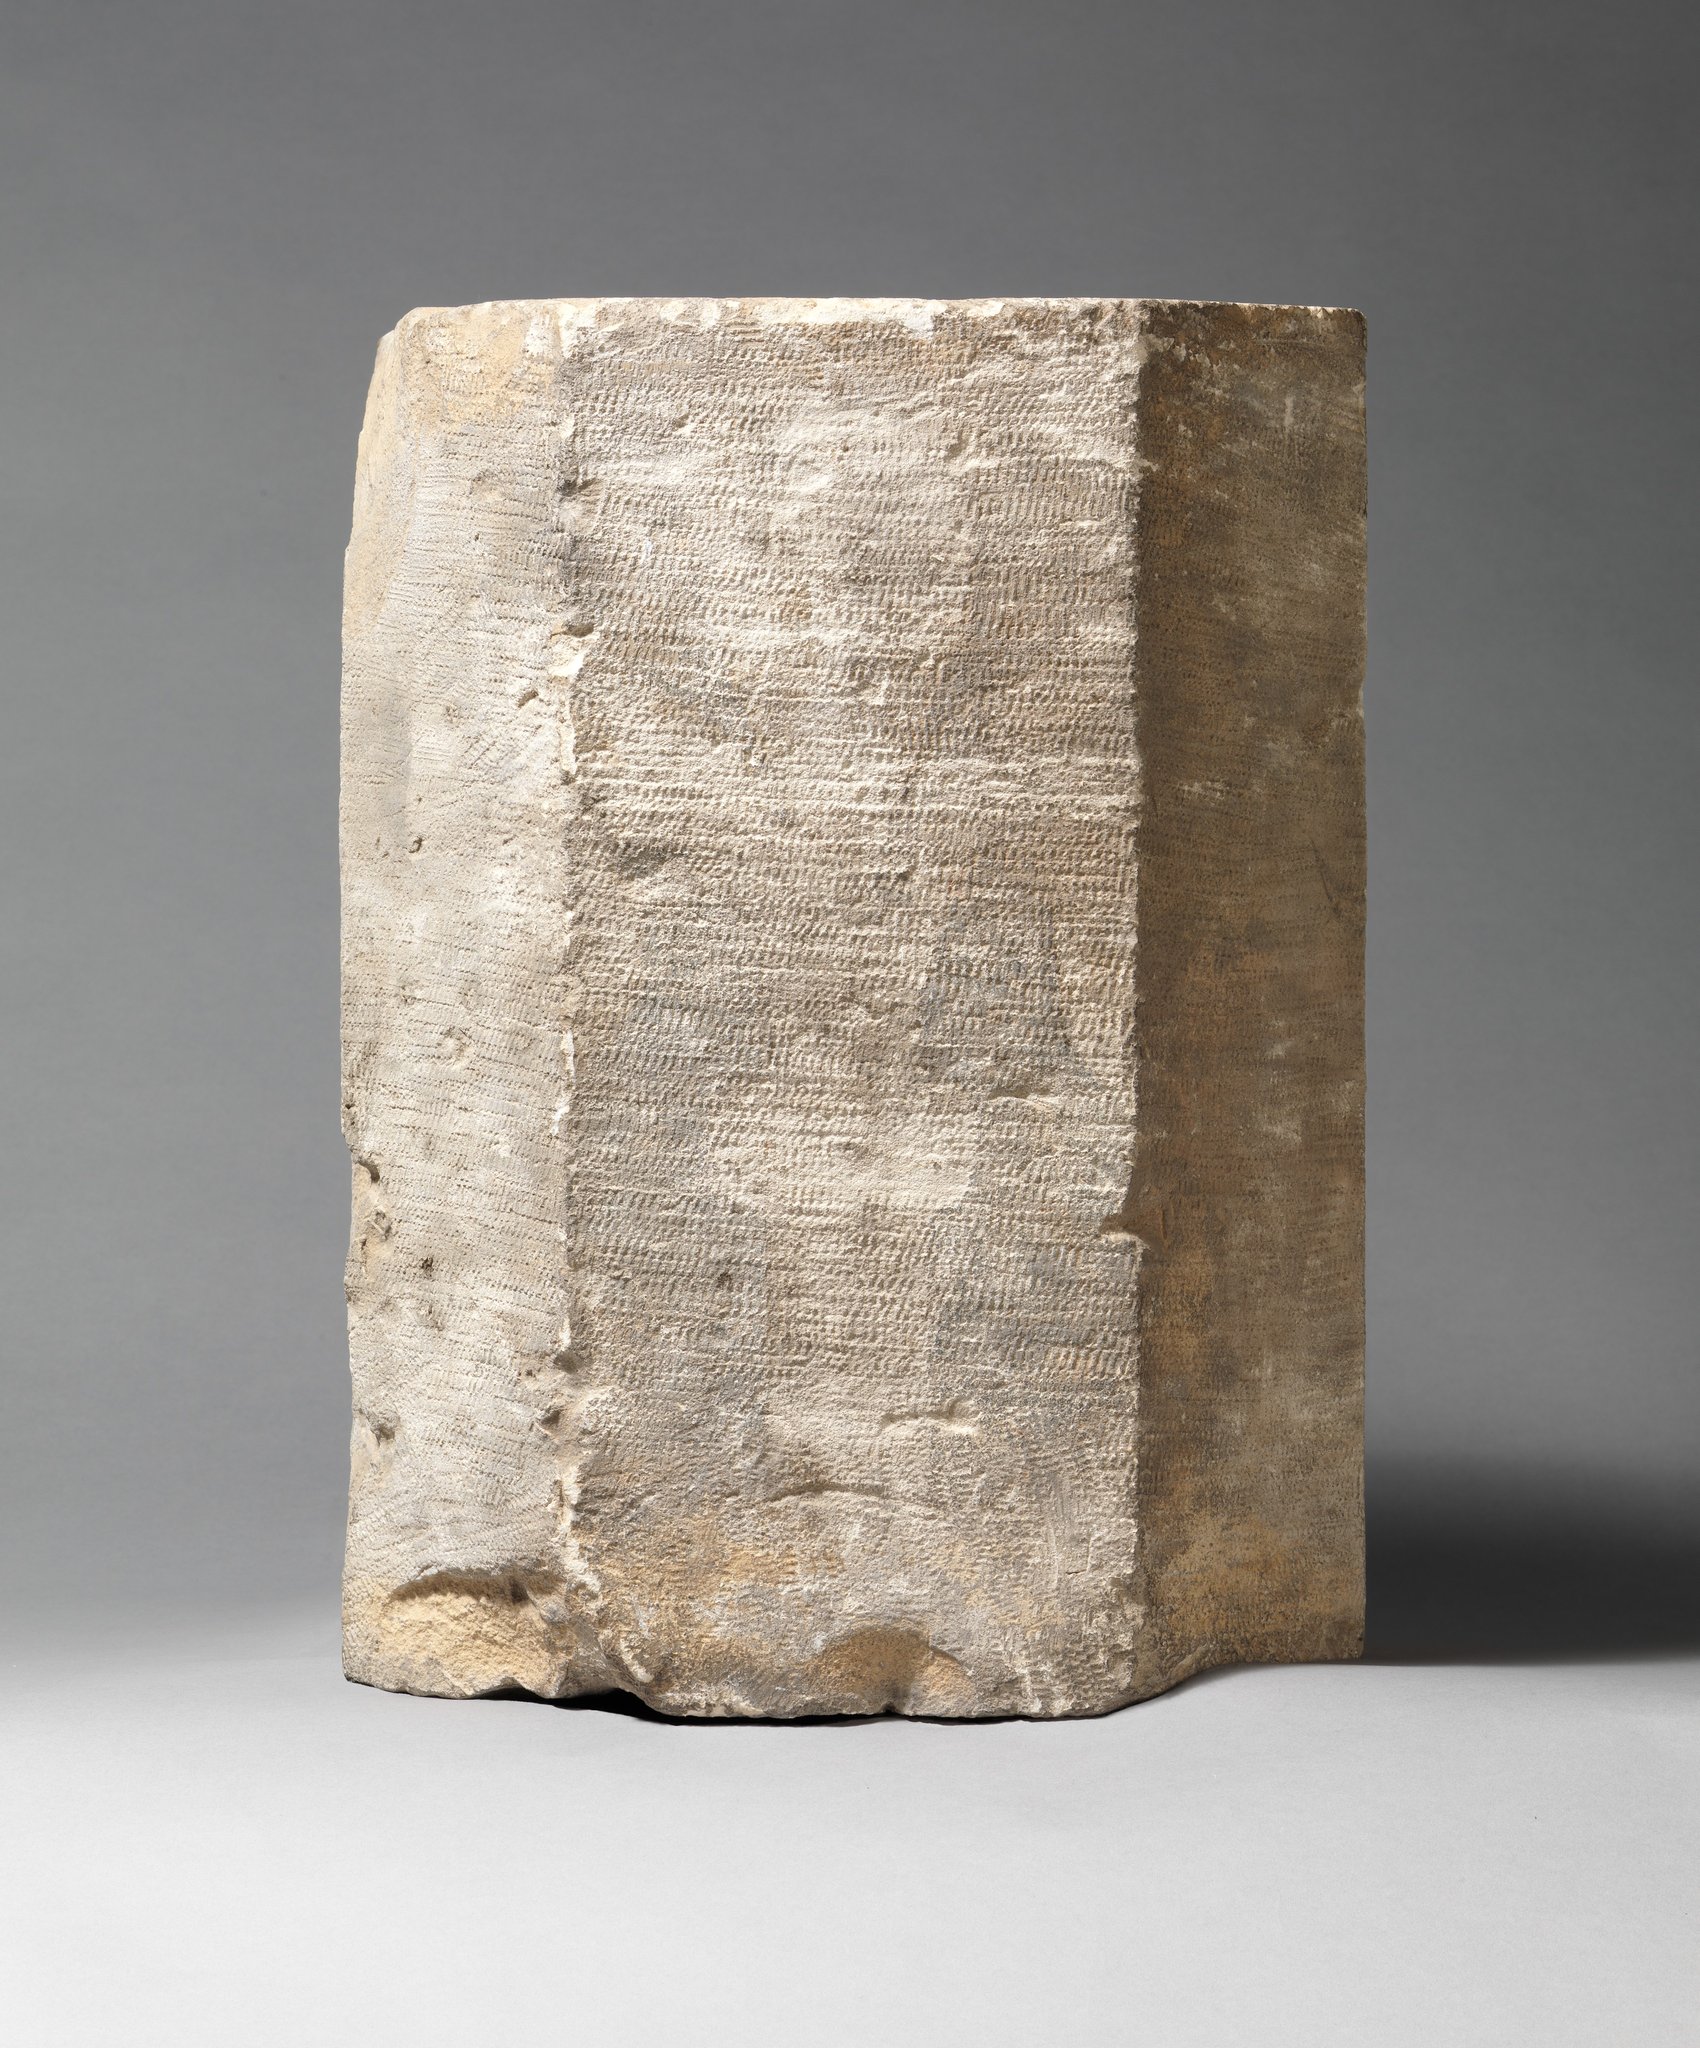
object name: rib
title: Rib from a Groined Ceiling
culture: french or german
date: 1201-1300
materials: stone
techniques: polychromy